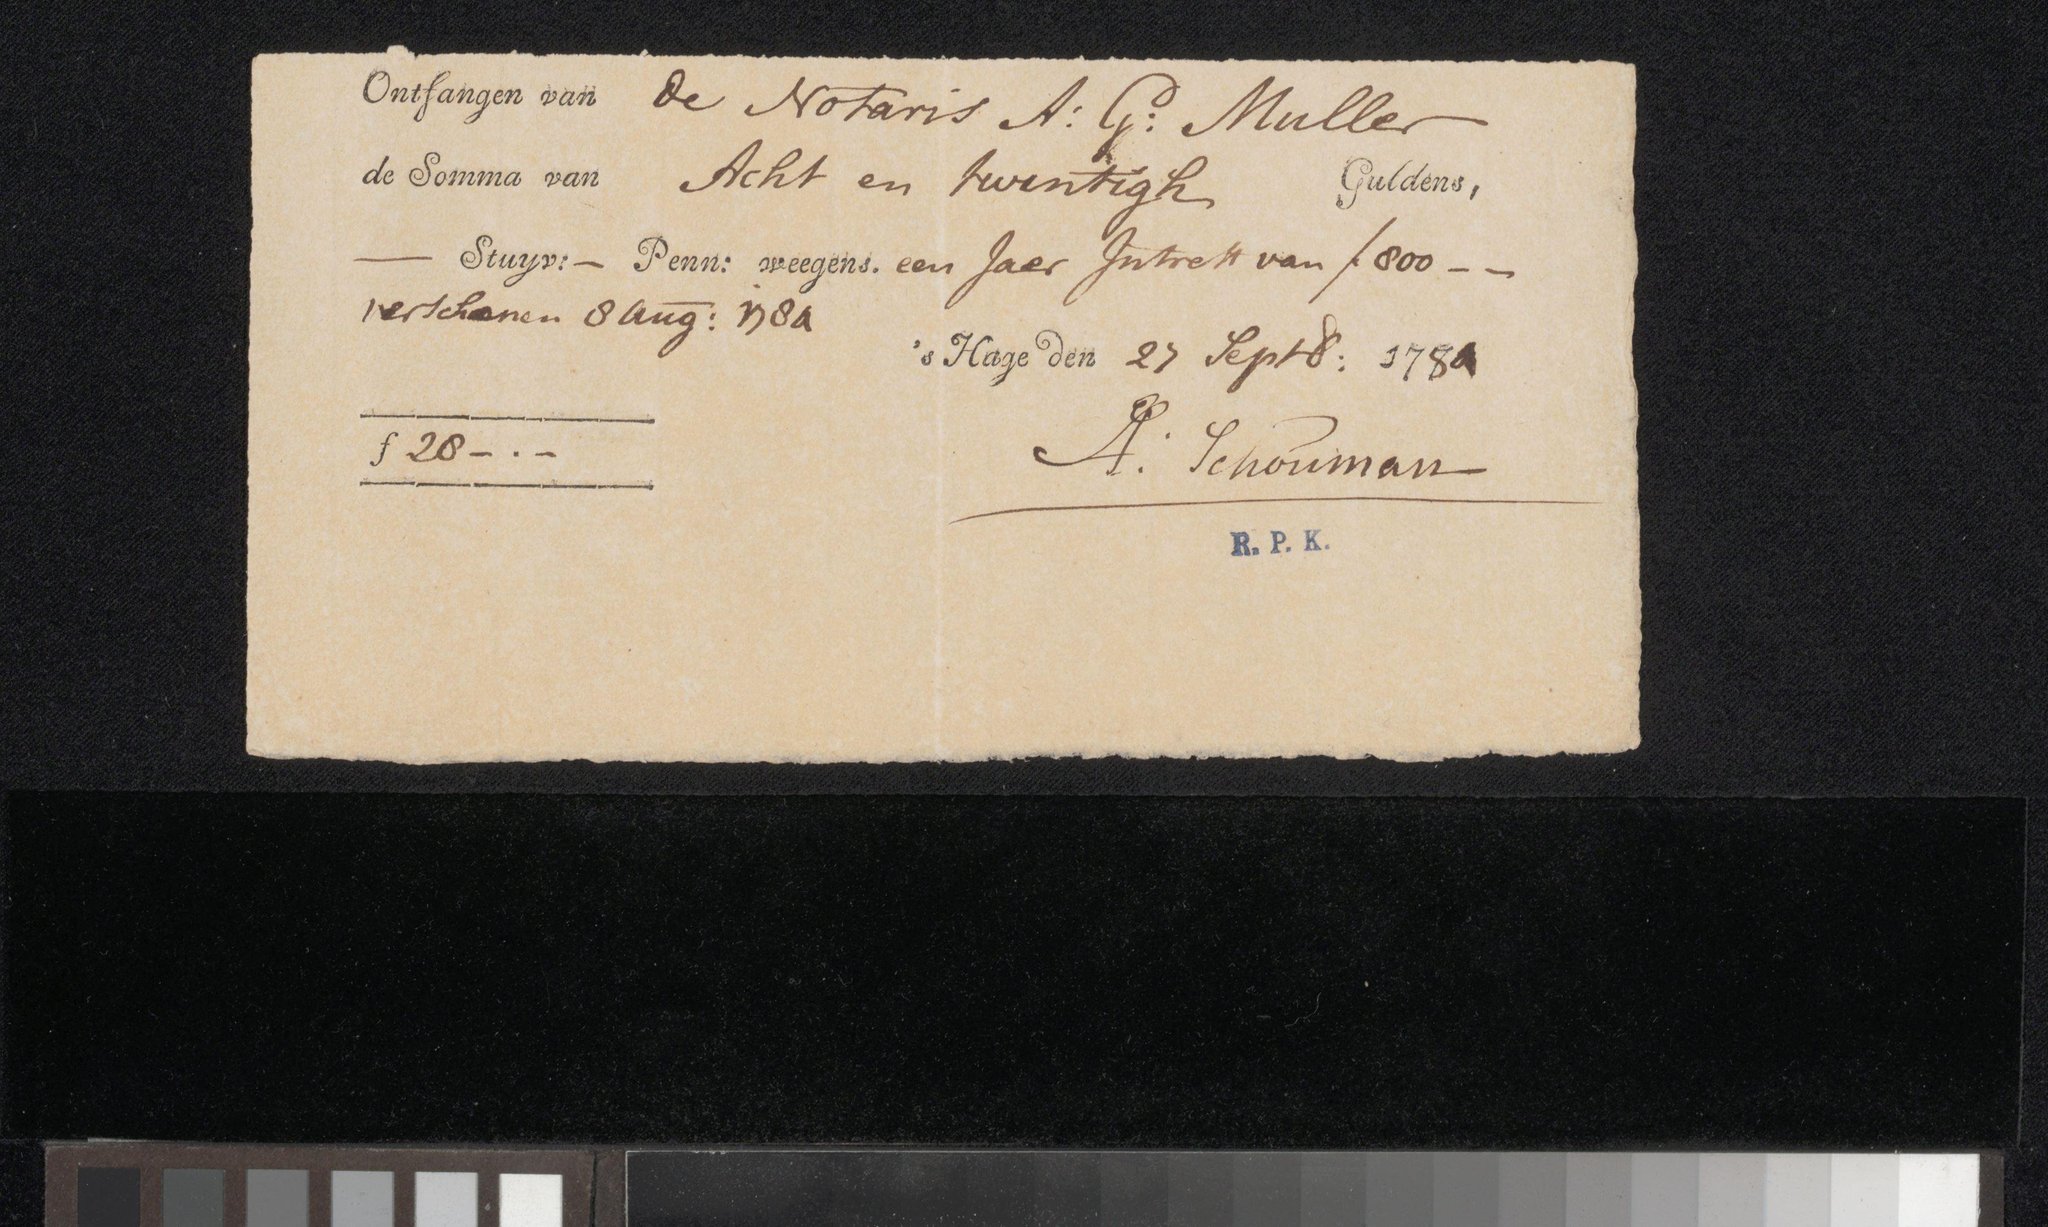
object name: ontvangstbewijs, kwitantie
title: Kwitantie voor Aert Schouman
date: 1784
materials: ink, paper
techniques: pen, printing, writing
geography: the hague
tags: money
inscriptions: collector's mark: Lugt 2233